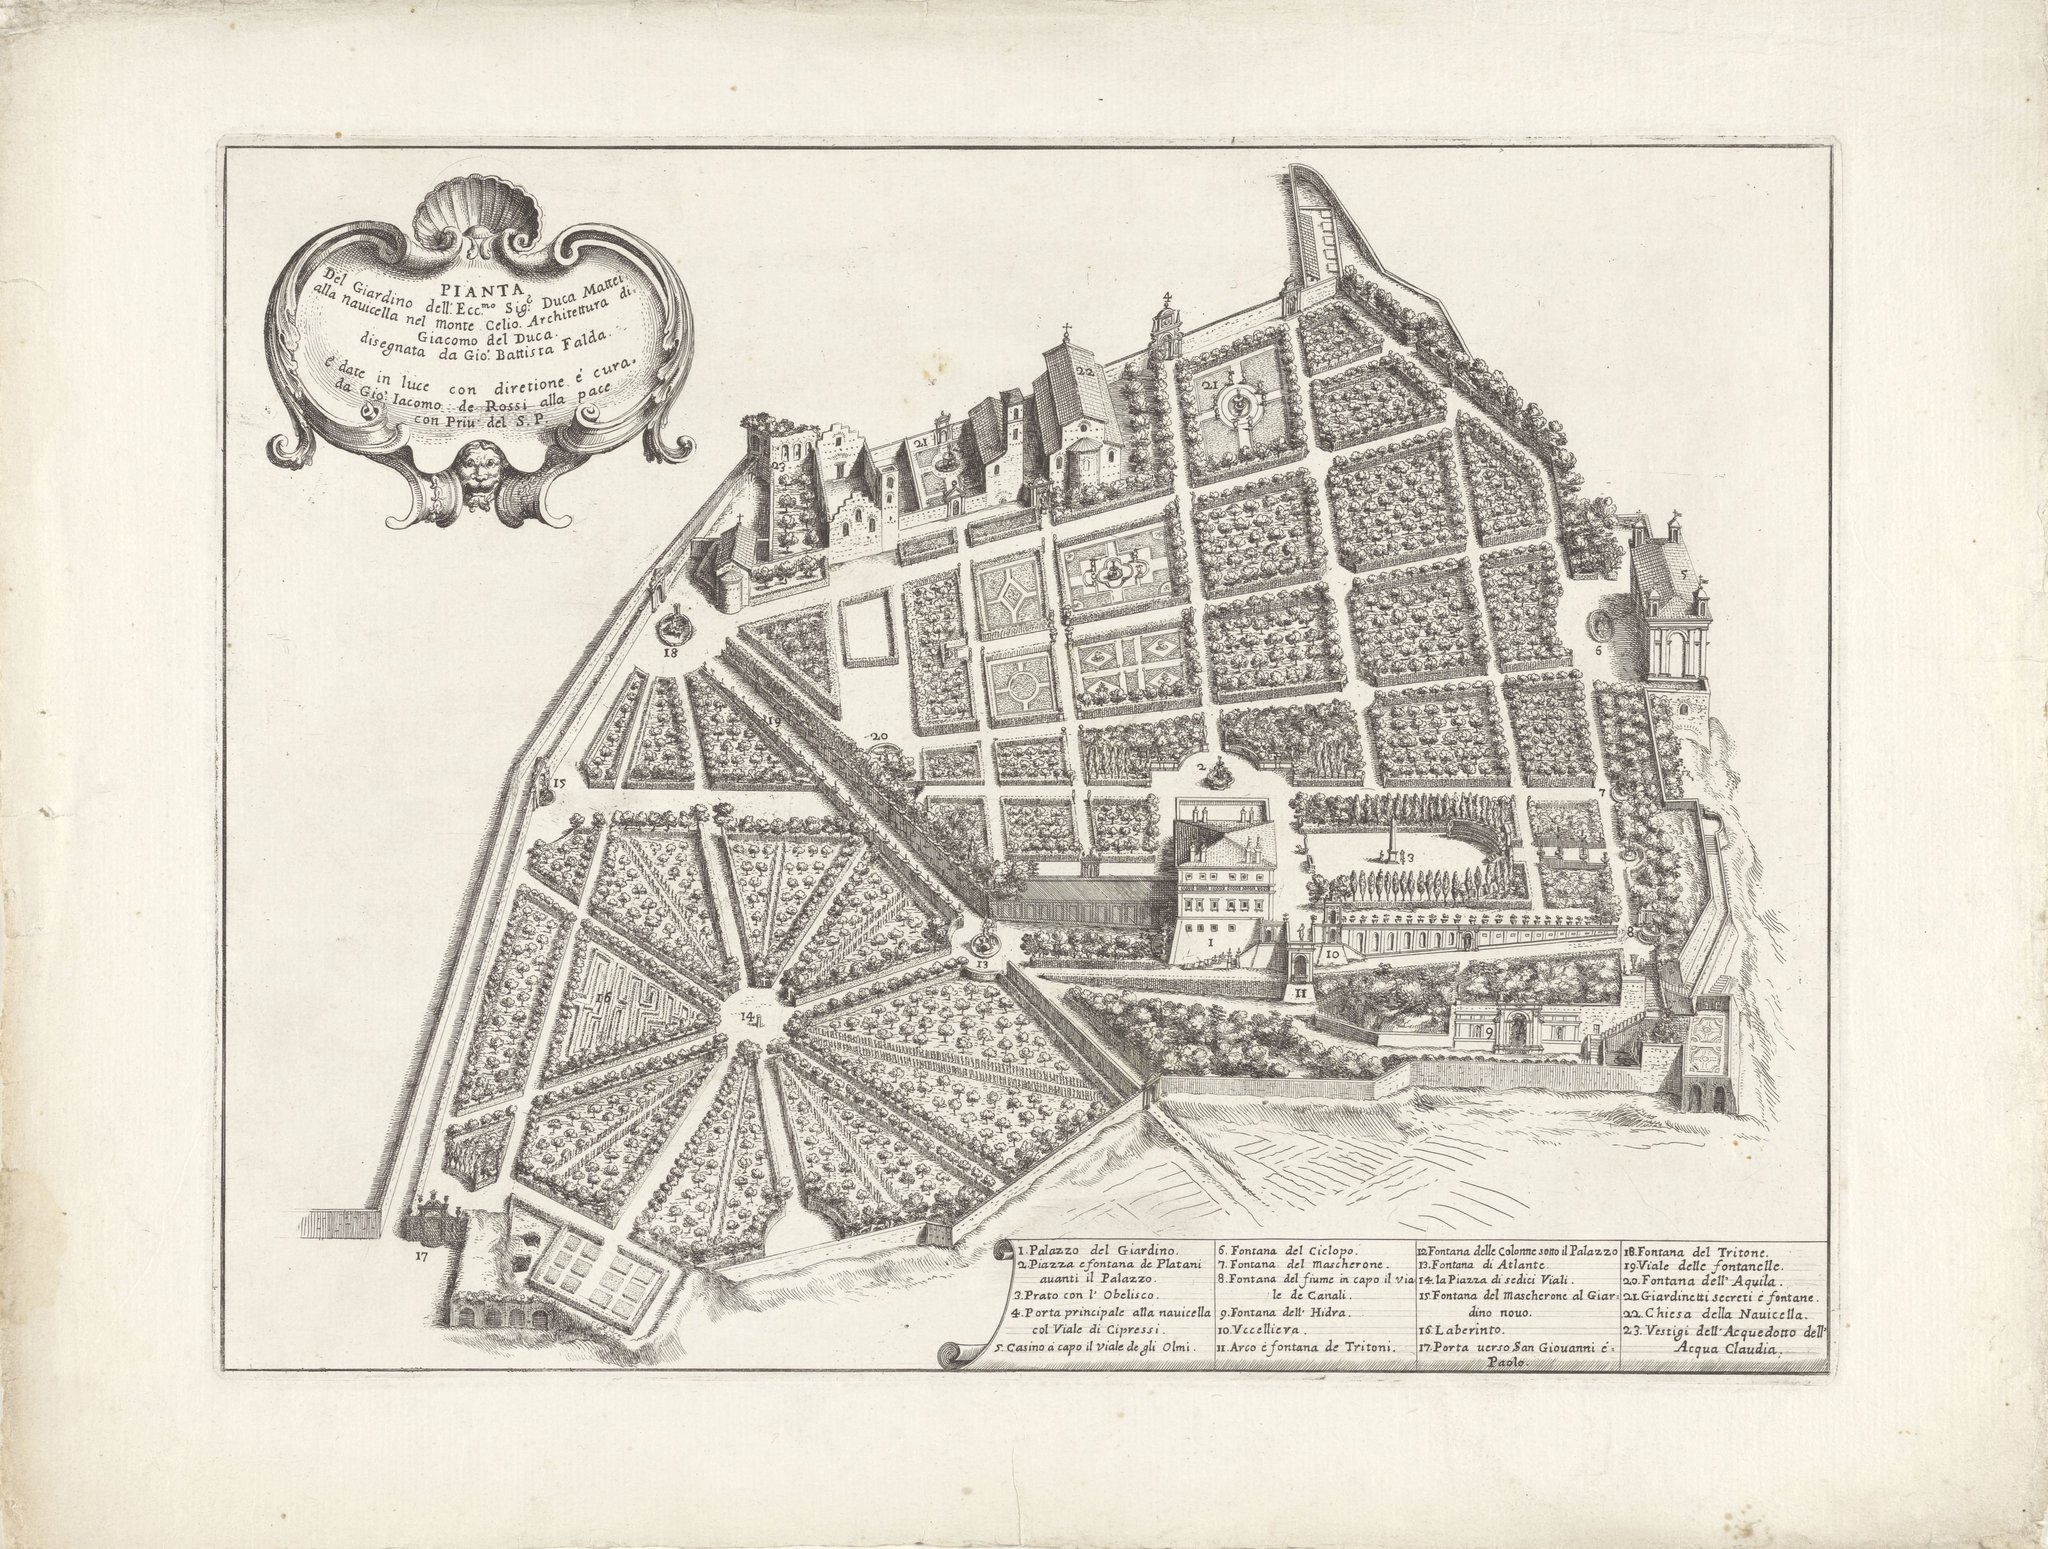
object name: print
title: Plattegrond van de tuin van hertog Girolamo Mattei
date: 1683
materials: paper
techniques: etching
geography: rome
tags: plan, map of garden, garden, rome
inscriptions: collector's mark: Lugt 2228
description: Plattegrond van de tuin van hertog Girolamo Mattei te Rome. Linksboven een cartouche met titel. Rechtsonder een tekstvak met verklarende lijst met nummers.